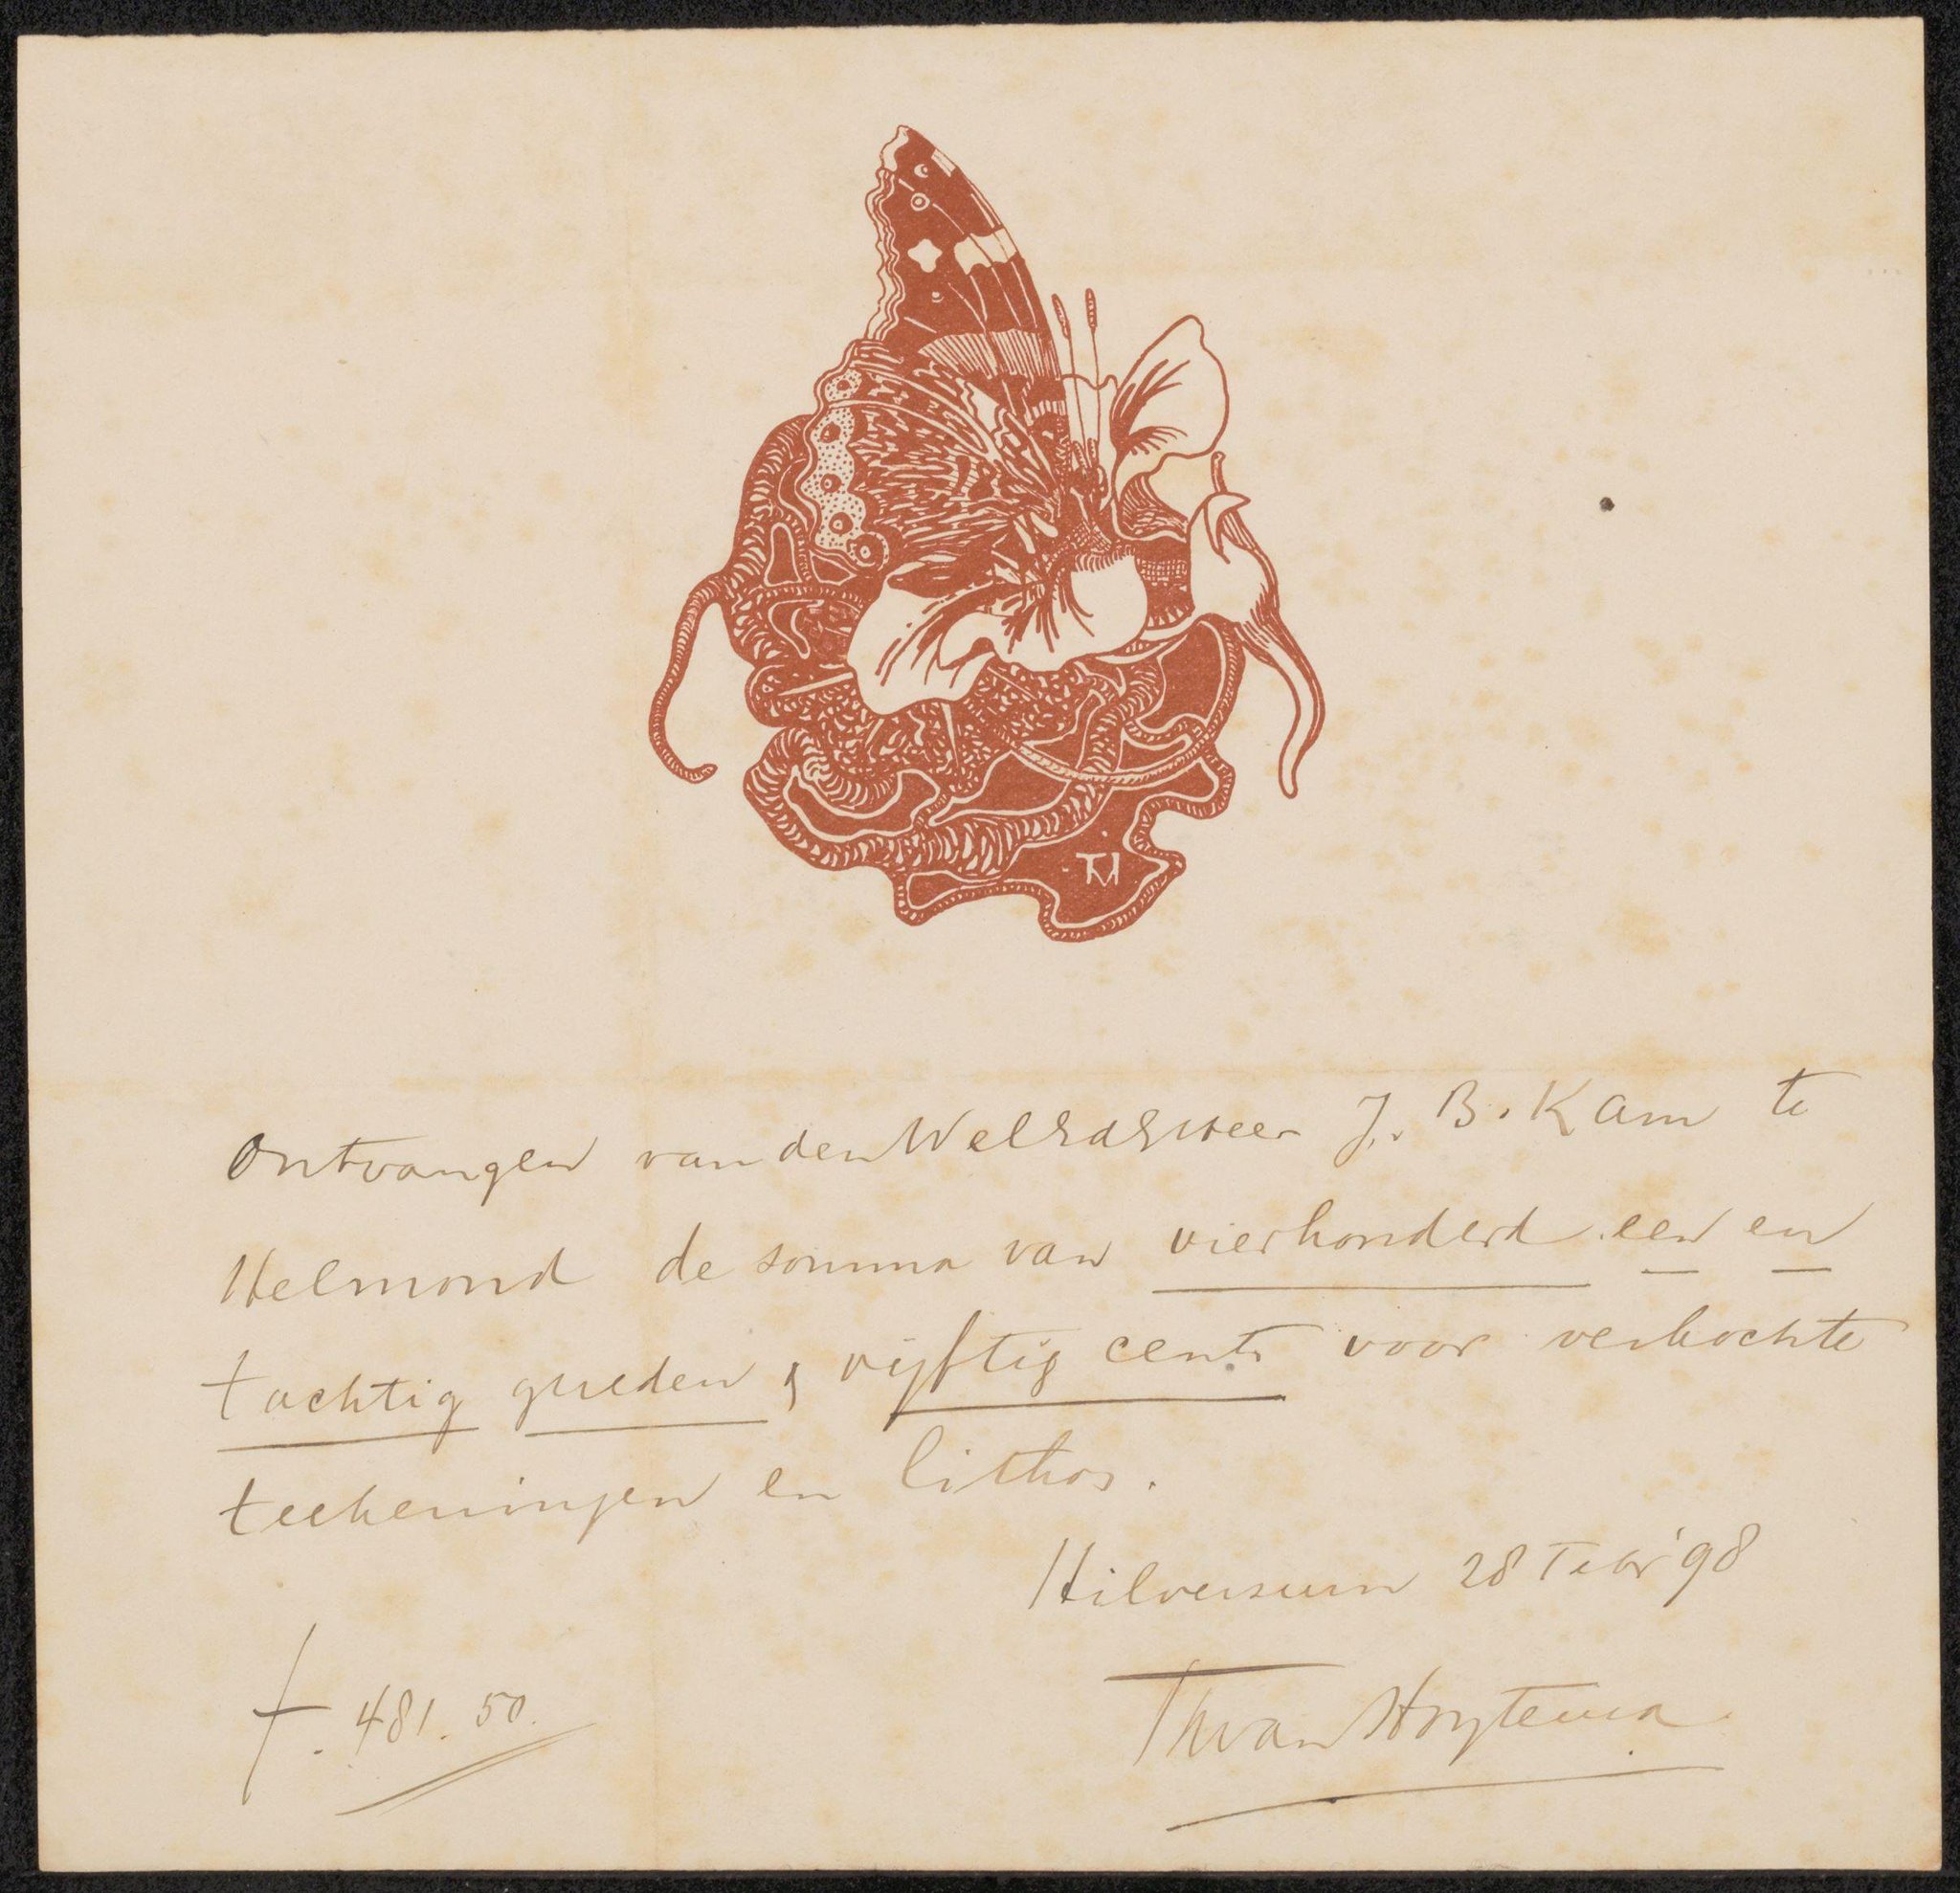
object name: ontvangstbewijs, kwitantie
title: Ontvangstbewijs aan J.B. Kam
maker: theo van hoytema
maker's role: draughtsman, painter, print maker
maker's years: 1863-1917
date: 1898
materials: ink, paper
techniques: pen, printing, writing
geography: hilversum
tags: manufacturer, art trade, art shop, drawing, the graphic arts, money